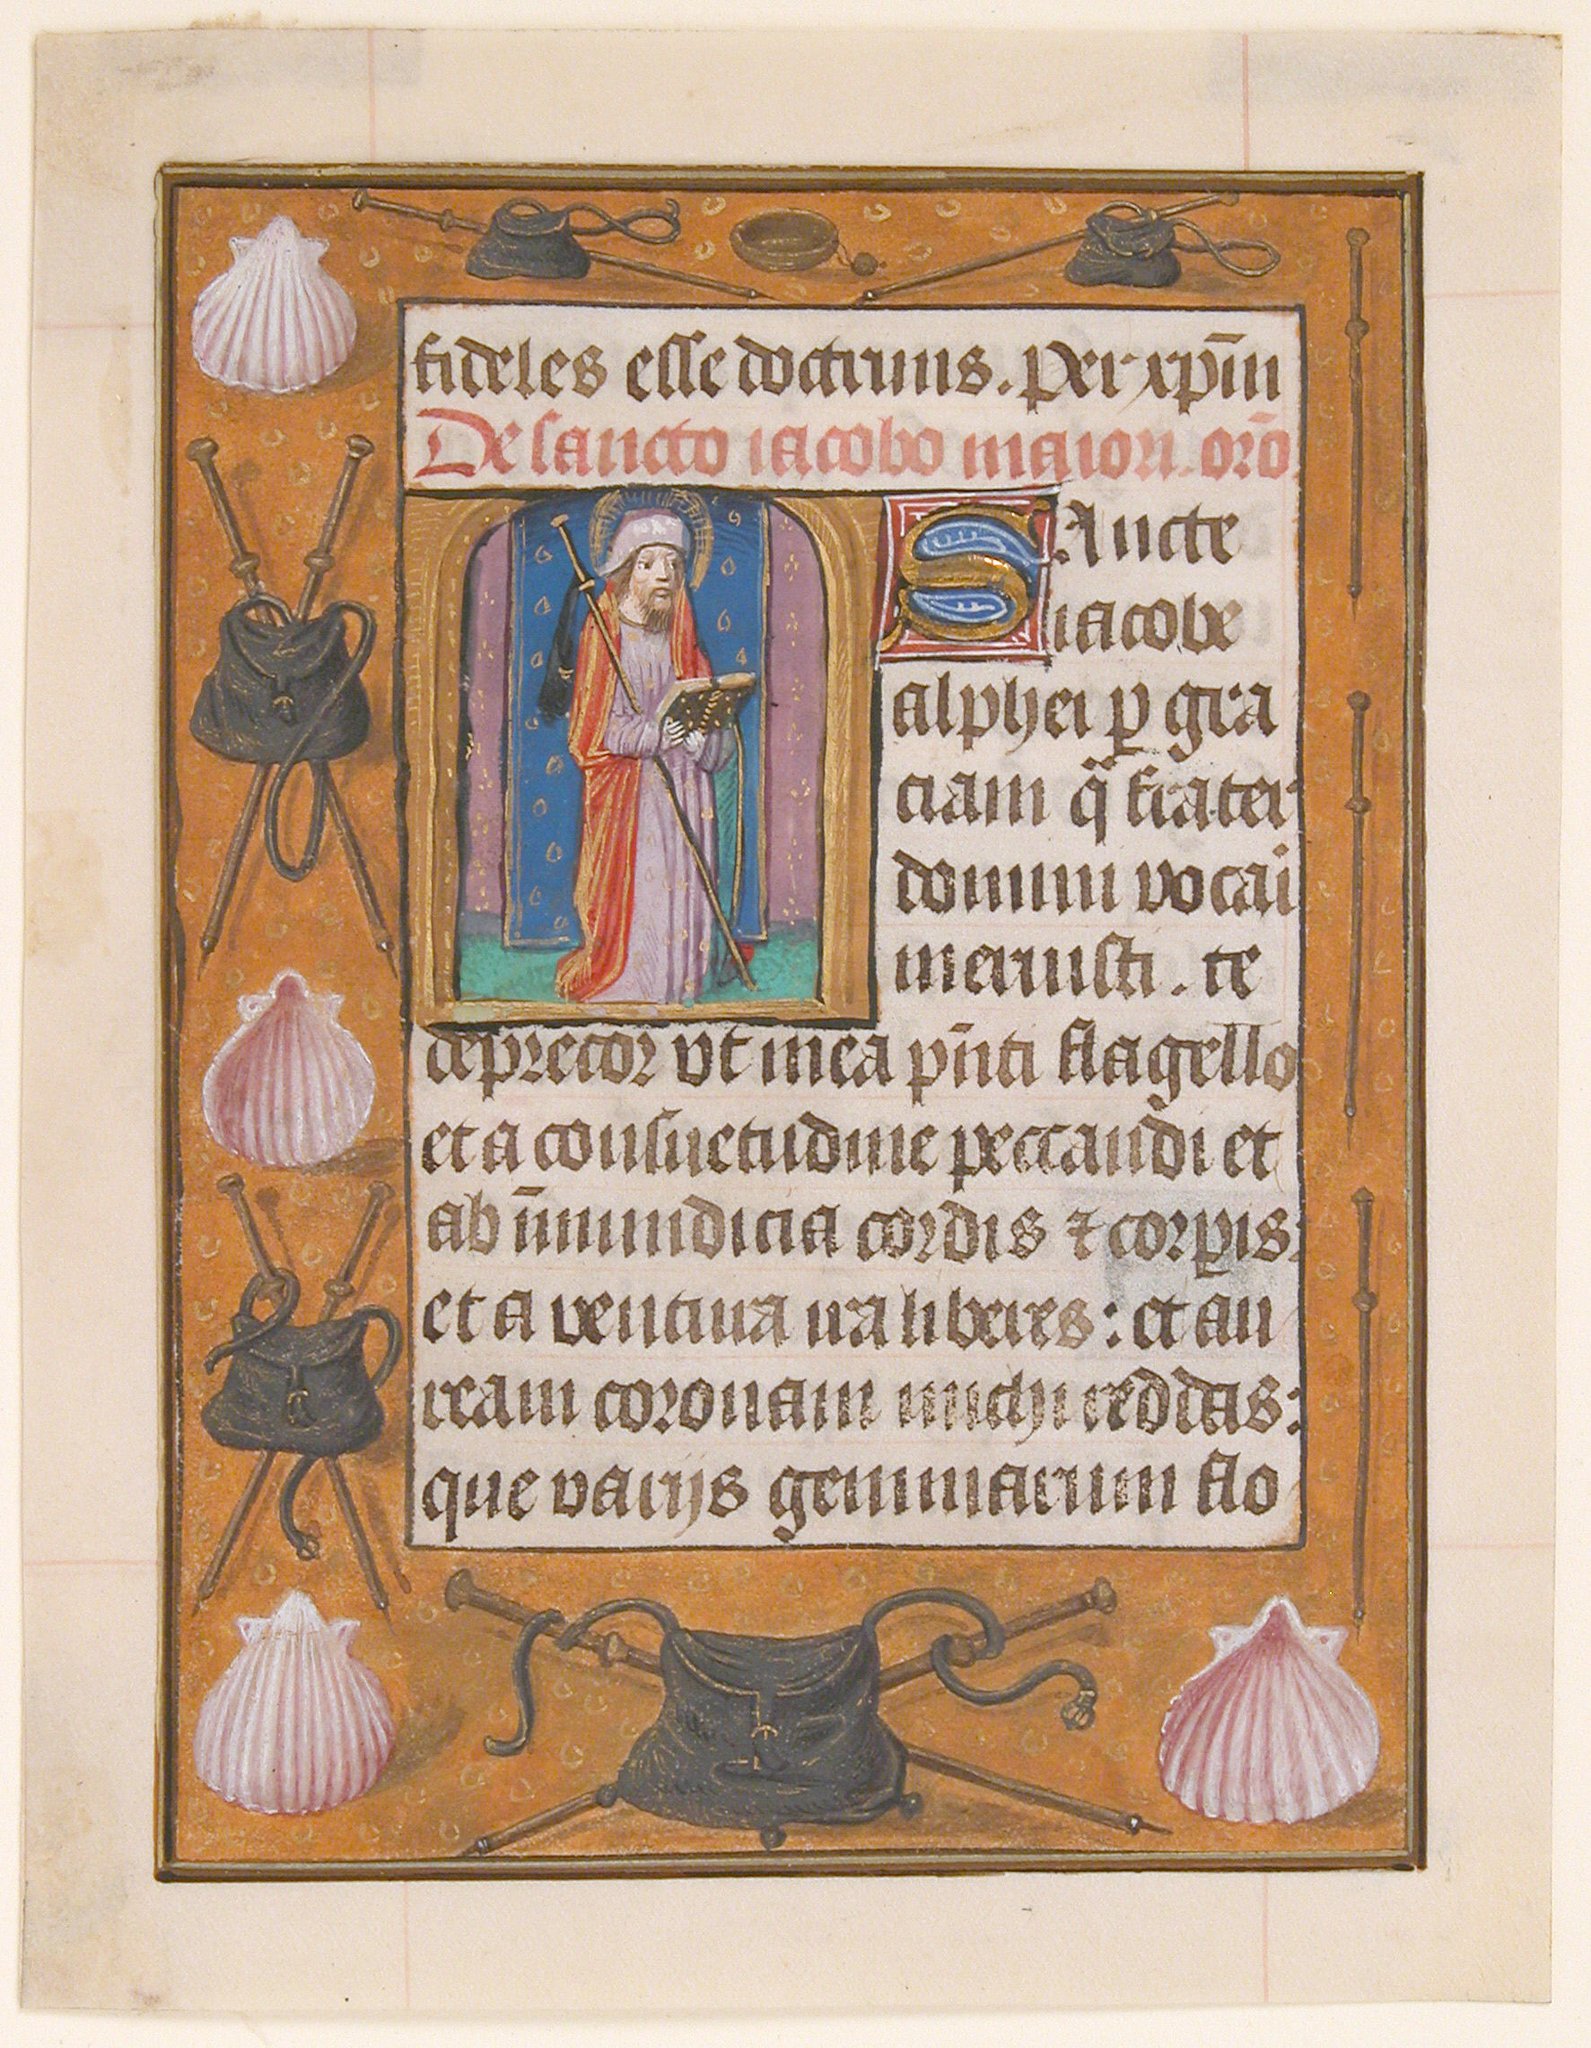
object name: book of hour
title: Manuscript Leaf with Saint James the Greater, from a Book of Hours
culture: dutch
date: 1500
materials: gold, ink, parchment, shell, paint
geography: netherlands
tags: shells,saints